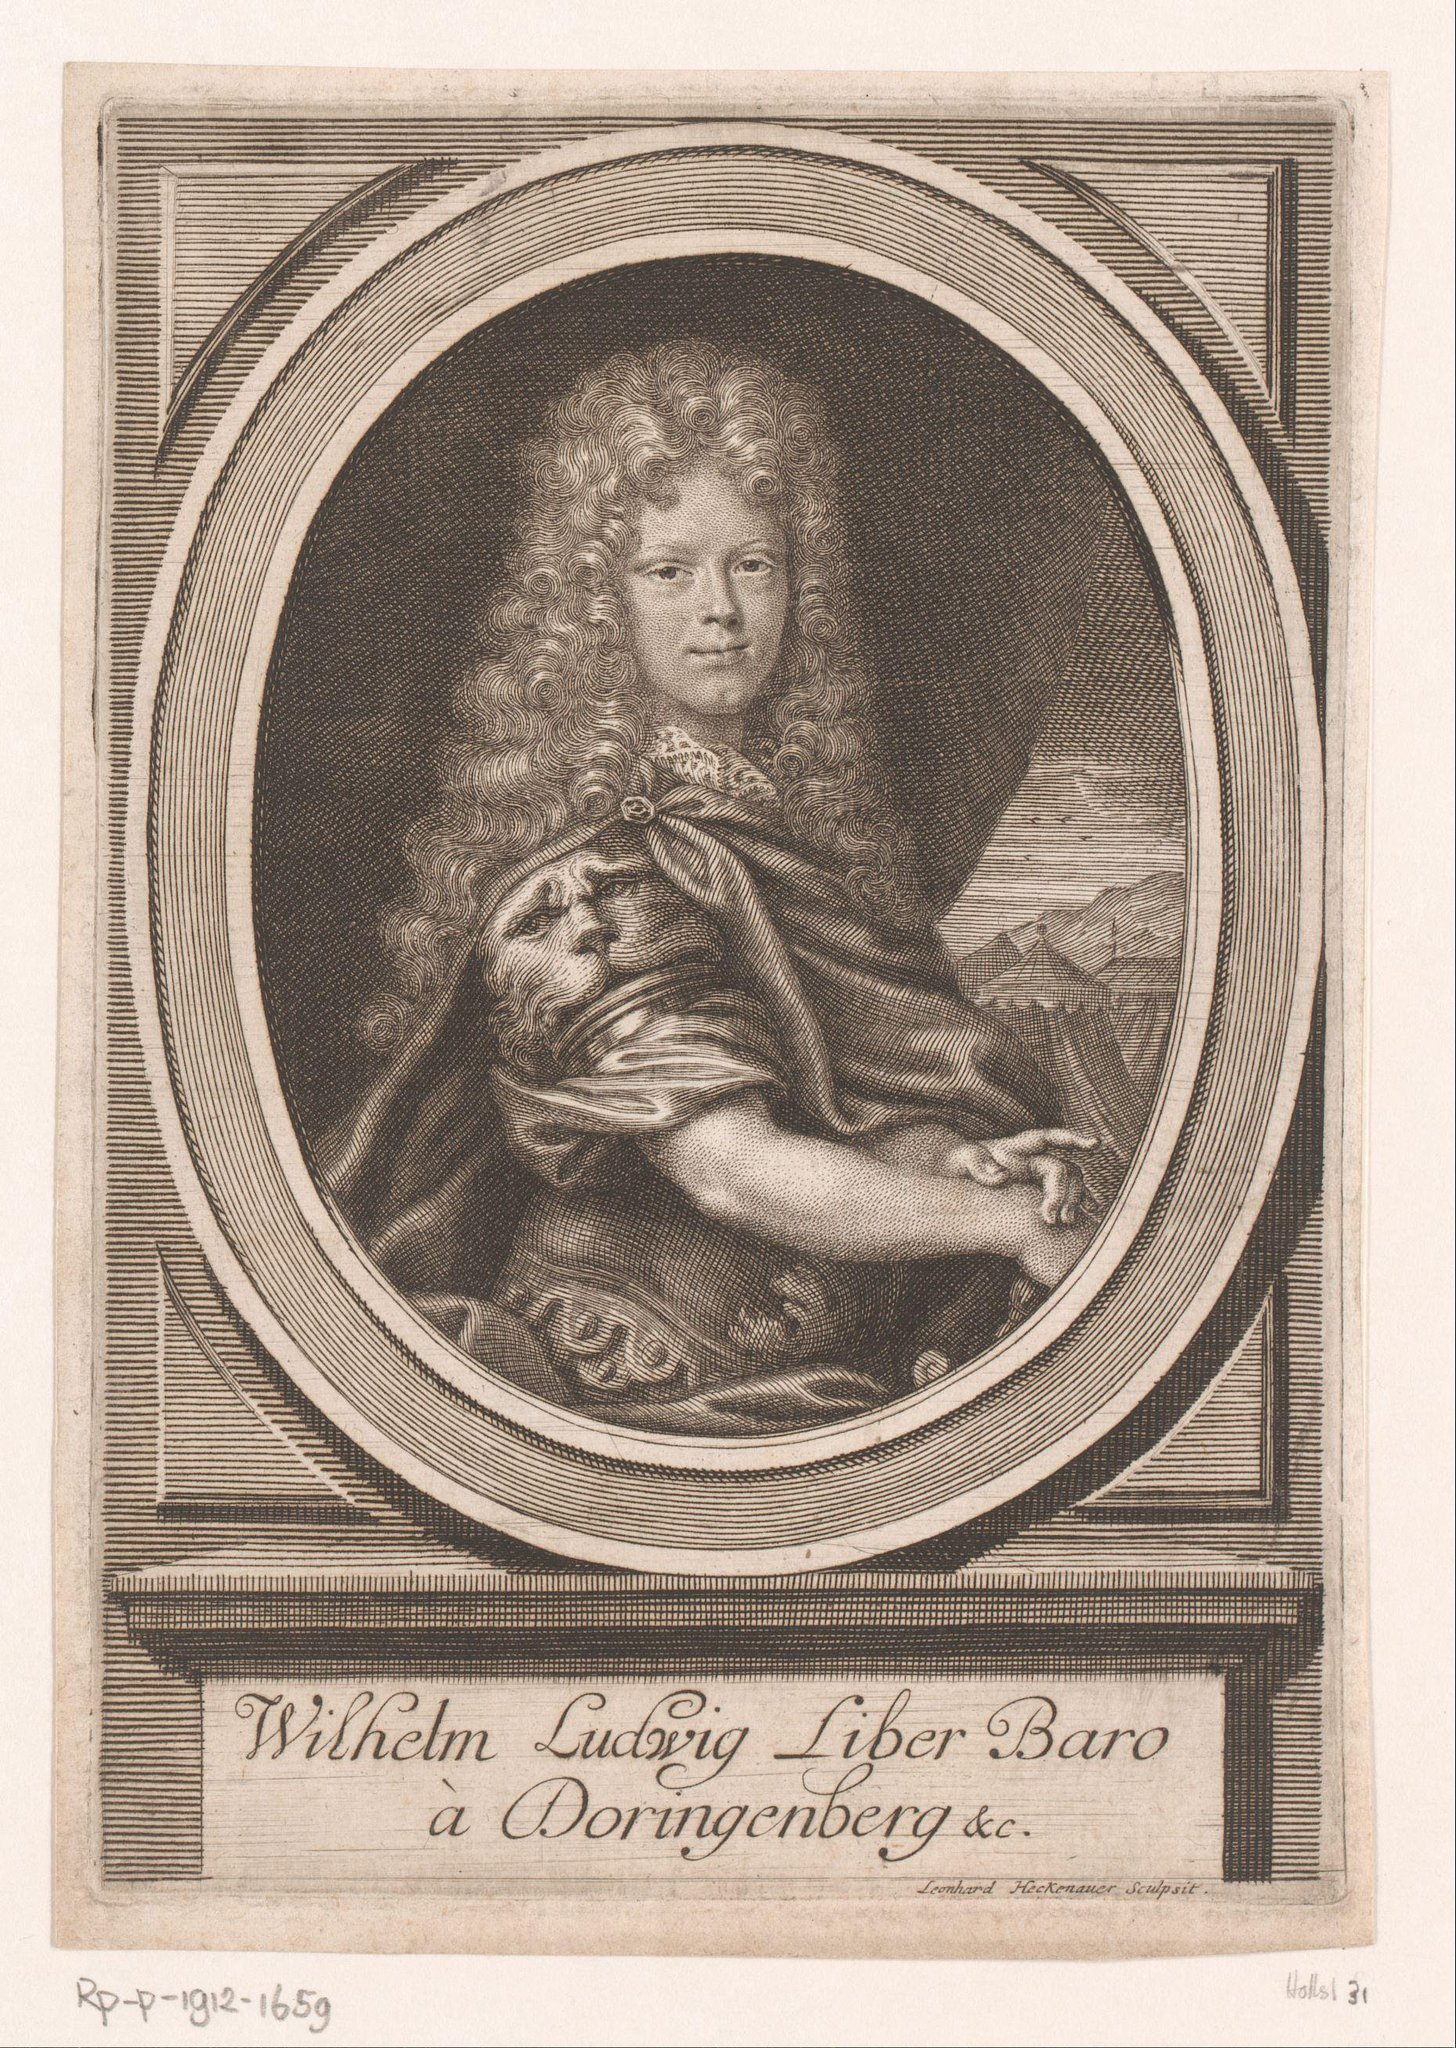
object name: print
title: Portret van Wilhelm-Ludwig von Döringenberg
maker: leonhard heckenauer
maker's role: print maker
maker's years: 1650-1704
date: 1671-1704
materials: paper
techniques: engraving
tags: (military) camp with tents, historical persons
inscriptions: collector's mark: Lugt 2228